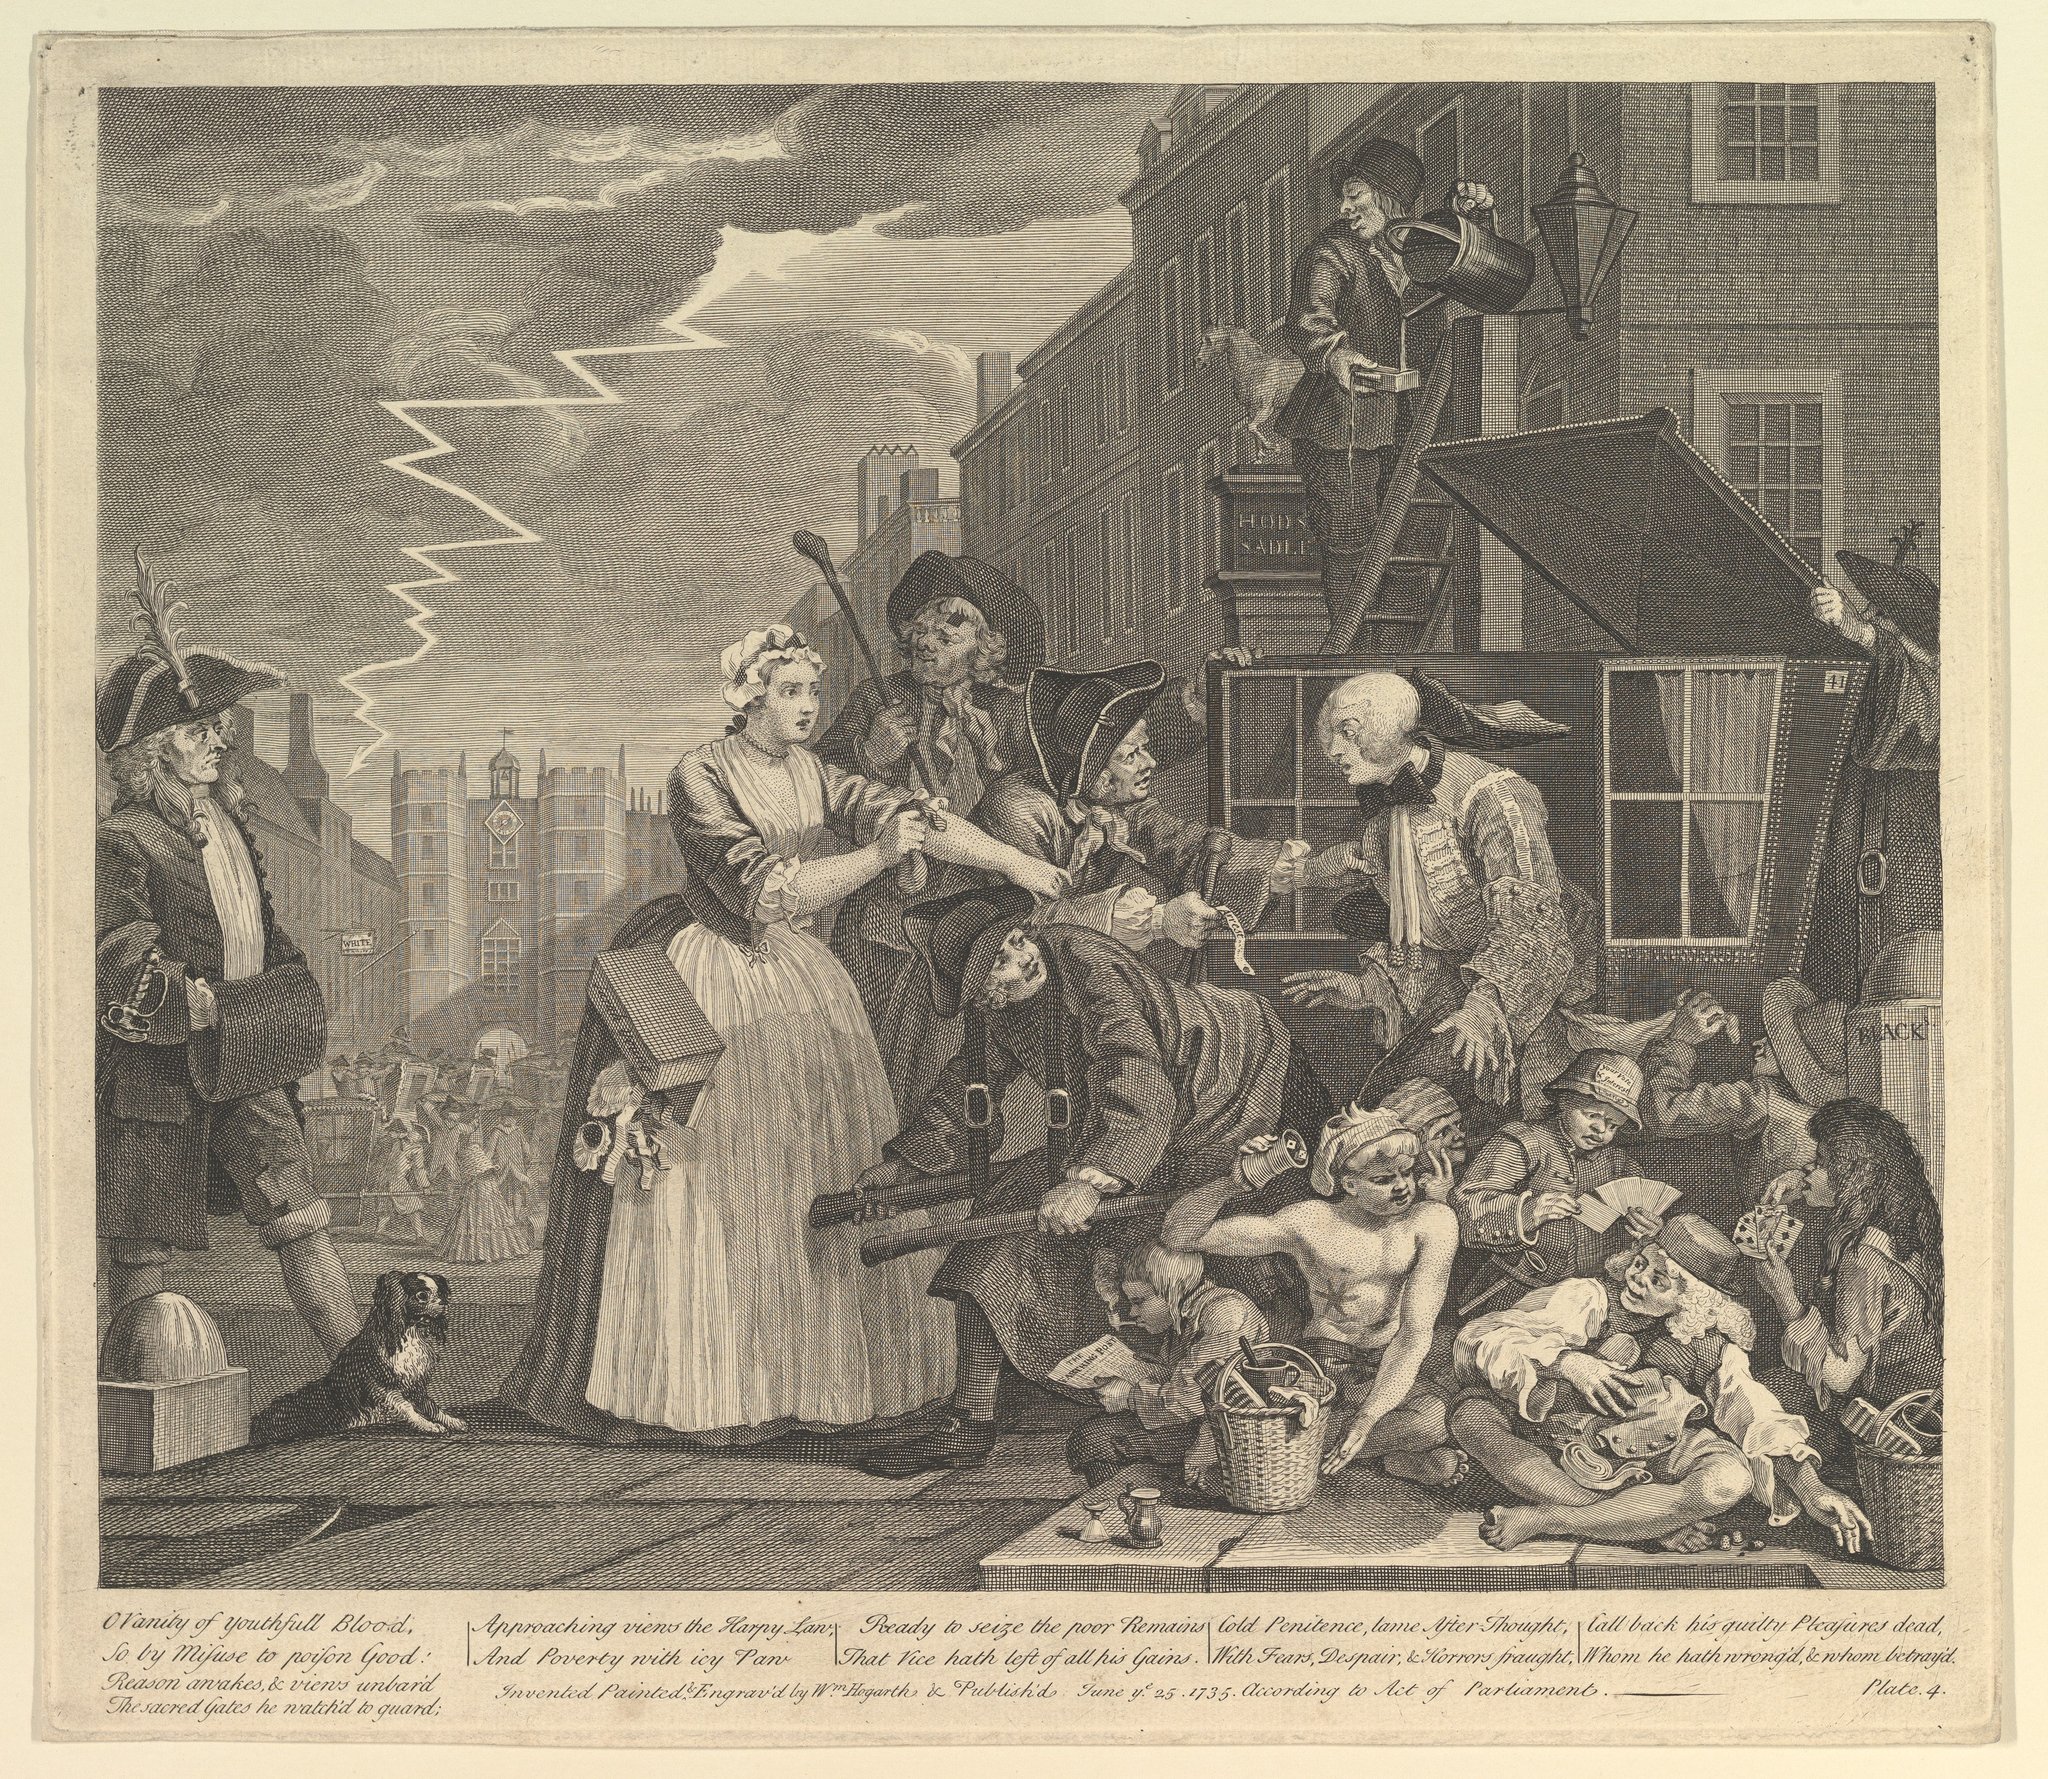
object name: print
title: A Rake's Progress, Plate 4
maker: william hogarth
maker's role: artist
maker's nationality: british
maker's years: 1697-1764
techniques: engraving, etching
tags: buildings,boys,men,women